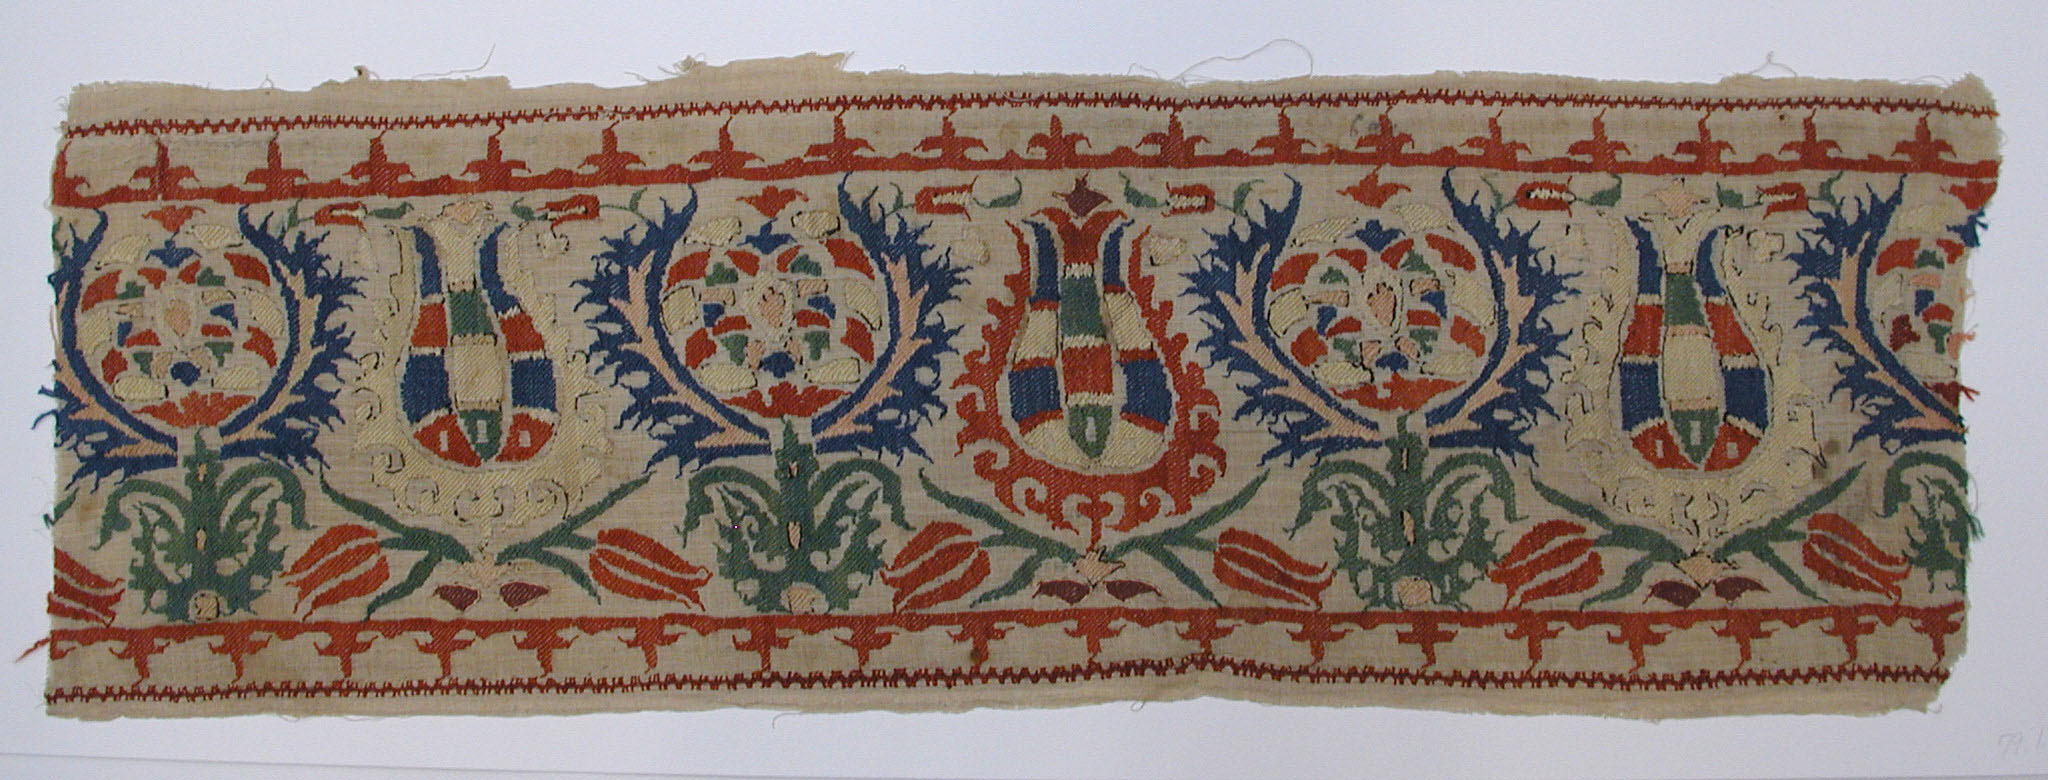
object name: textile fragment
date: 1701-1800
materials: linen, silk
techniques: embroidery, weave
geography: bulgaria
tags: flowers